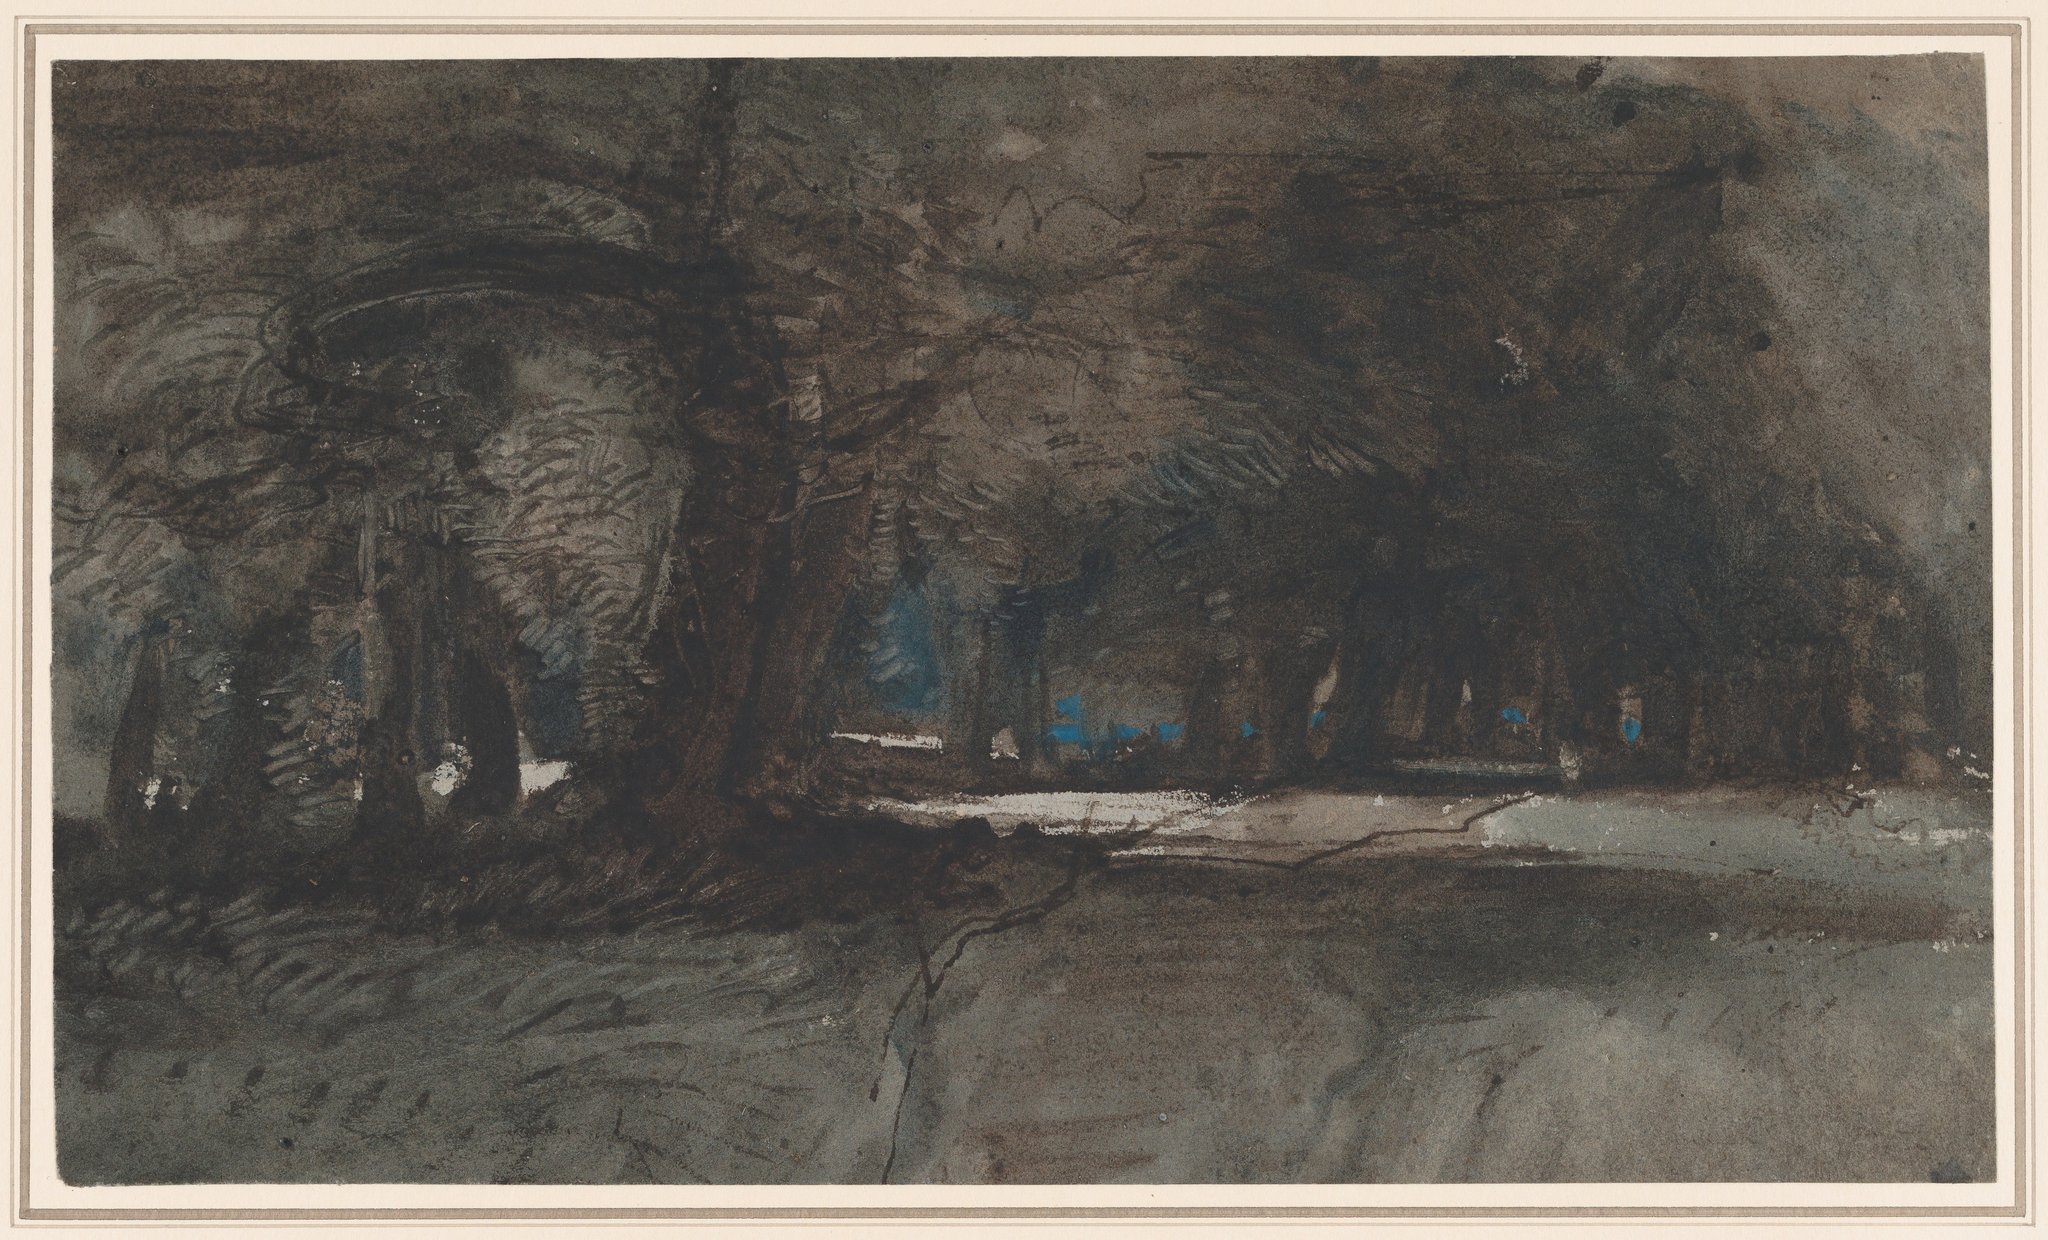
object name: drawing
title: A woodland scene at dusk (recto); A study of trees and foliage (verso)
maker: william james müller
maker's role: artist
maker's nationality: british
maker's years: 1812-1845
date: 1833-1845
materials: gouache, graphite, gum arabic, paper, watercolor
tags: trees,evening